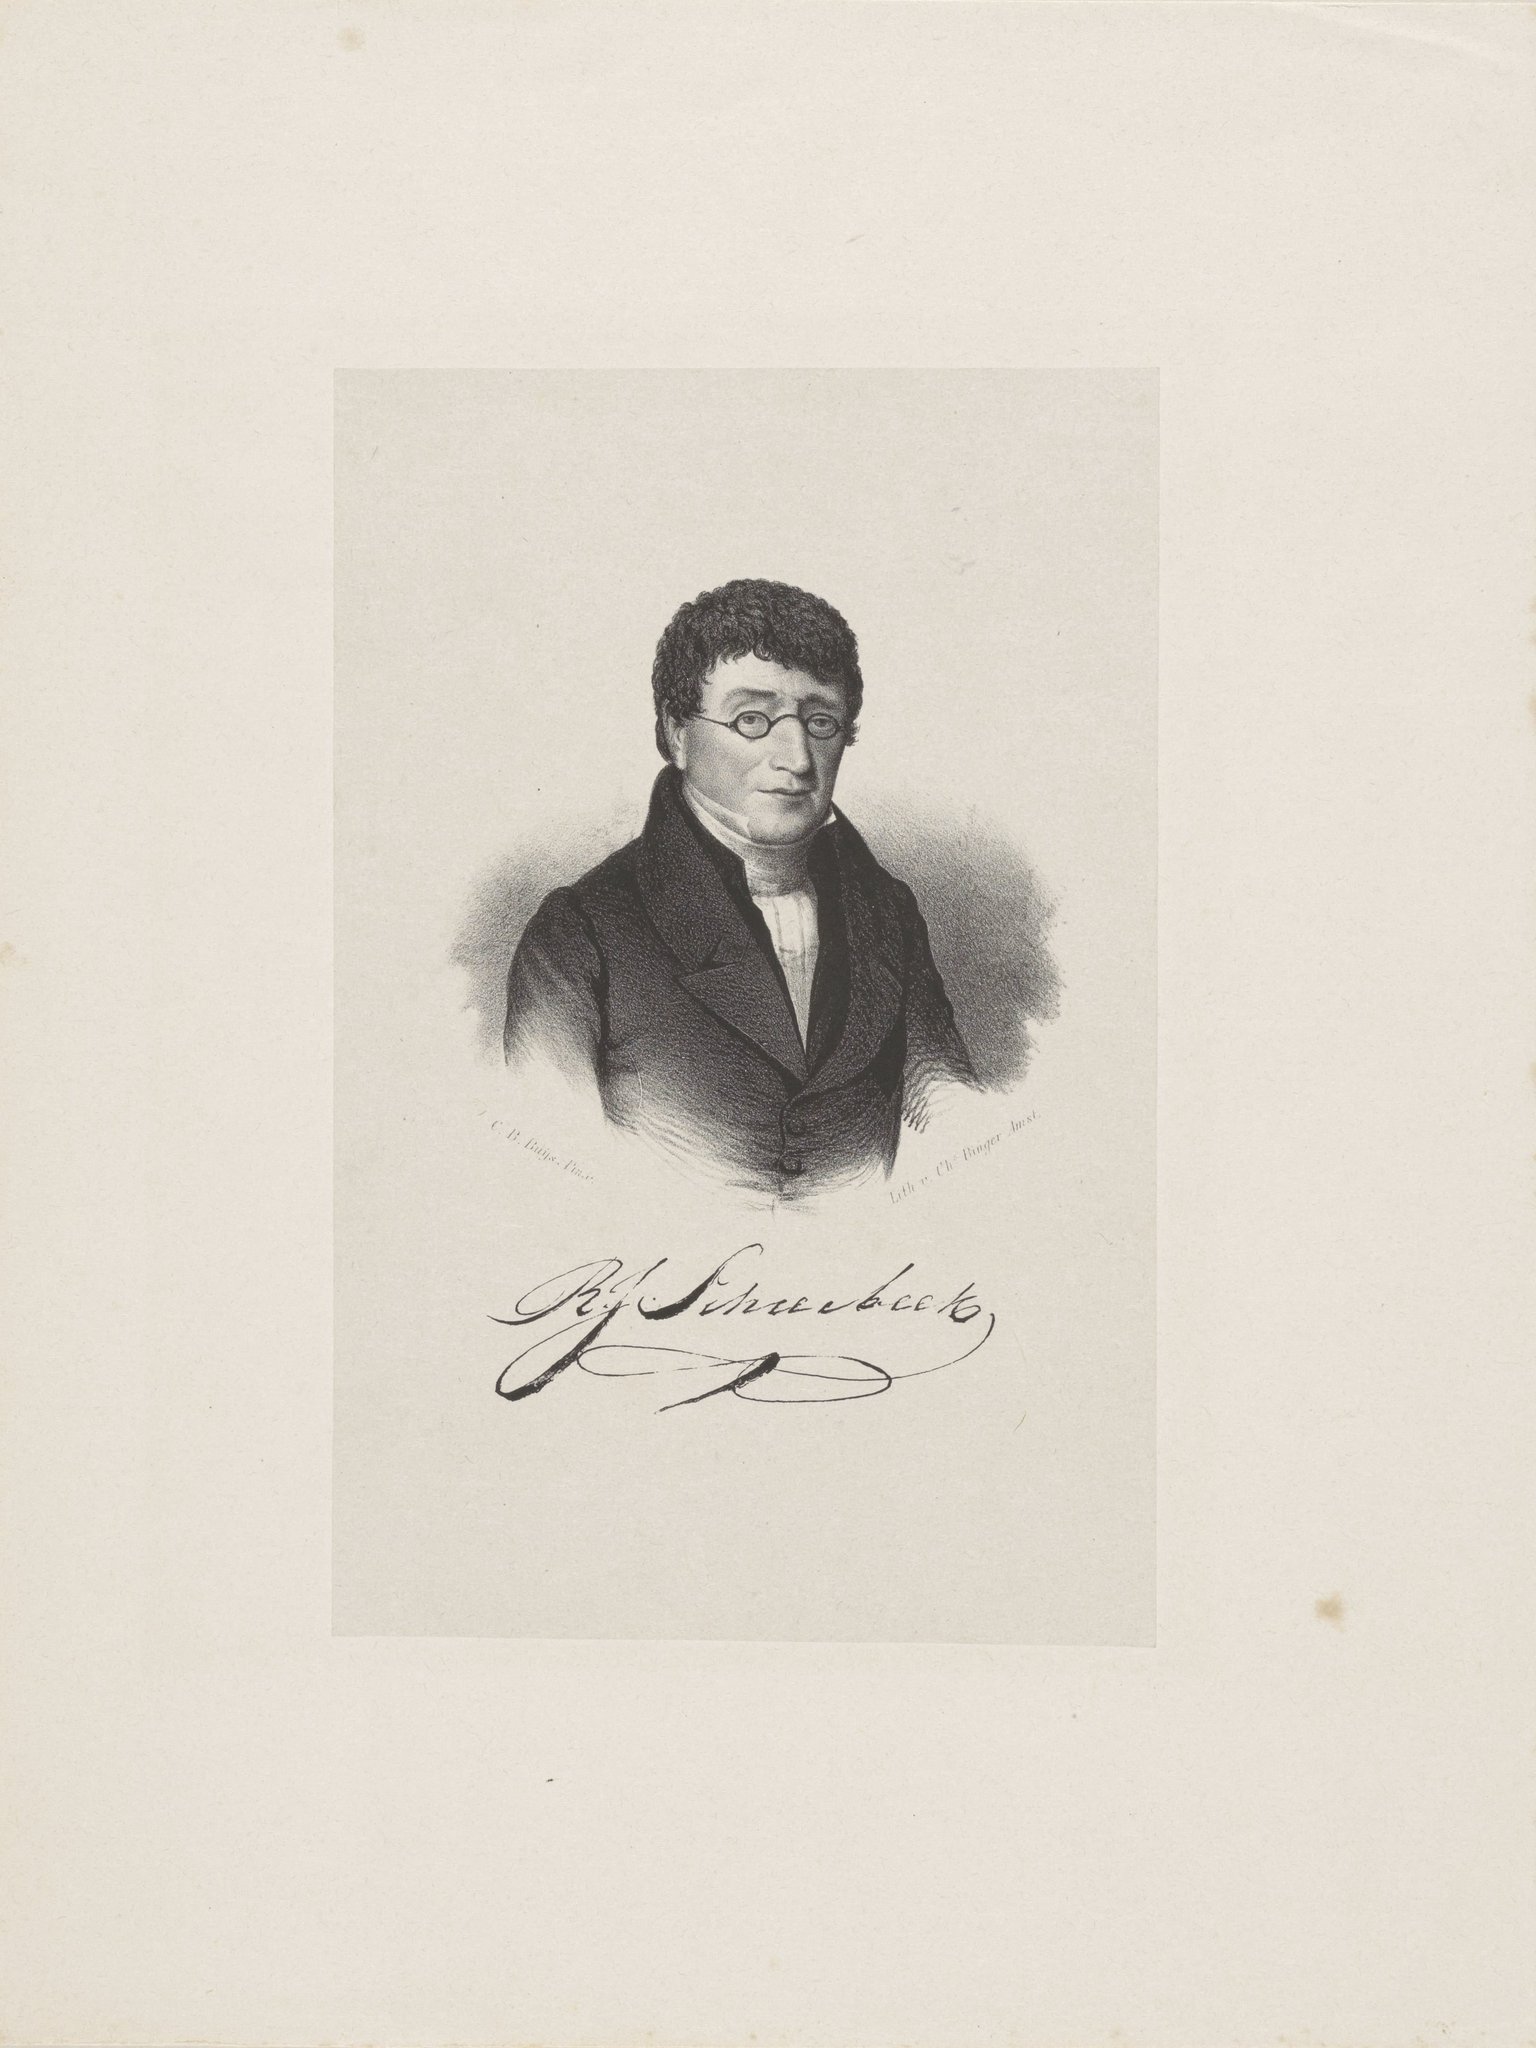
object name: print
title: Portret van Roelof Jacob Schierbeek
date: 1840-1891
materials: paper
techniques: lithograph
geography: amsterdam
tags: publisher, roelof jacob schierbeek, eyeglasses, spectacles, historical persons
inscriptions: collector's mark: Lugt 2228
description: De geportretteerde draagt een bril. Onder het portret zijn signatuur.